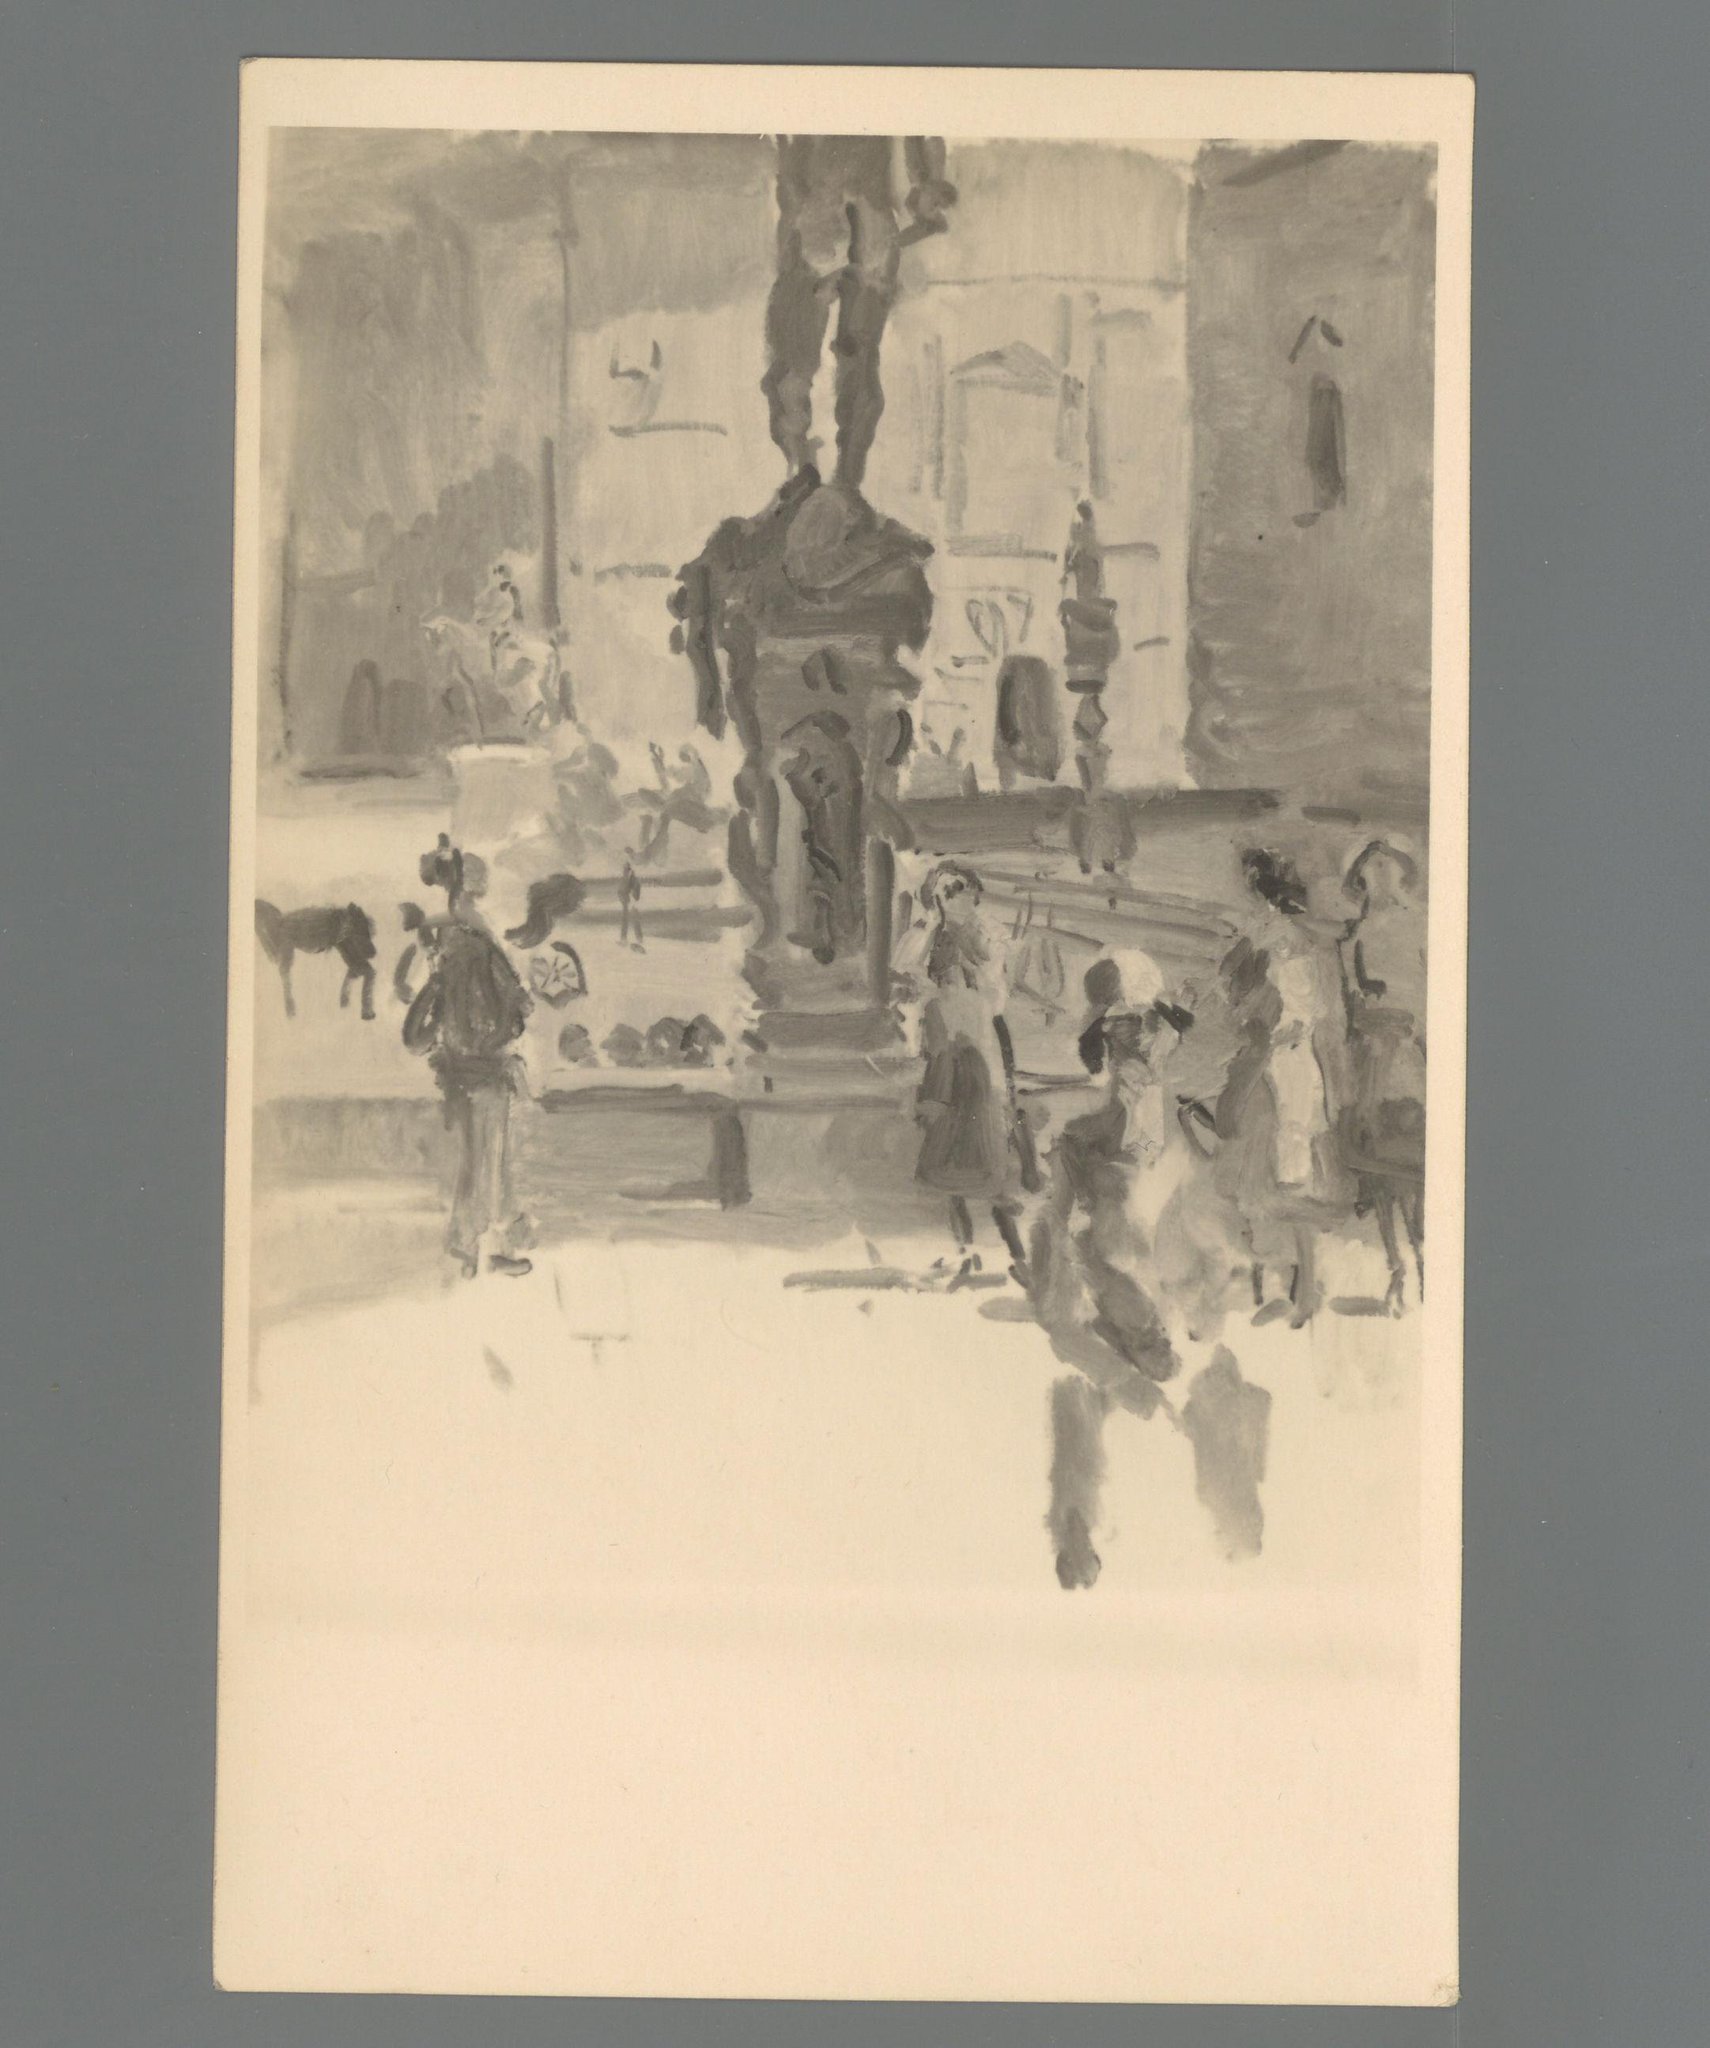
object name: photograph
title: Piazza della Signoria met standbeeld van Perseus in Florence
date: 1927-1935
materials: photographic support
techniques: photography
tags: monument, statue, square, place, circus, etc. (+ city(-scape) with figures, staffage), (story of) perseus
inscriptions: collector's mark: ‘AFE v S’